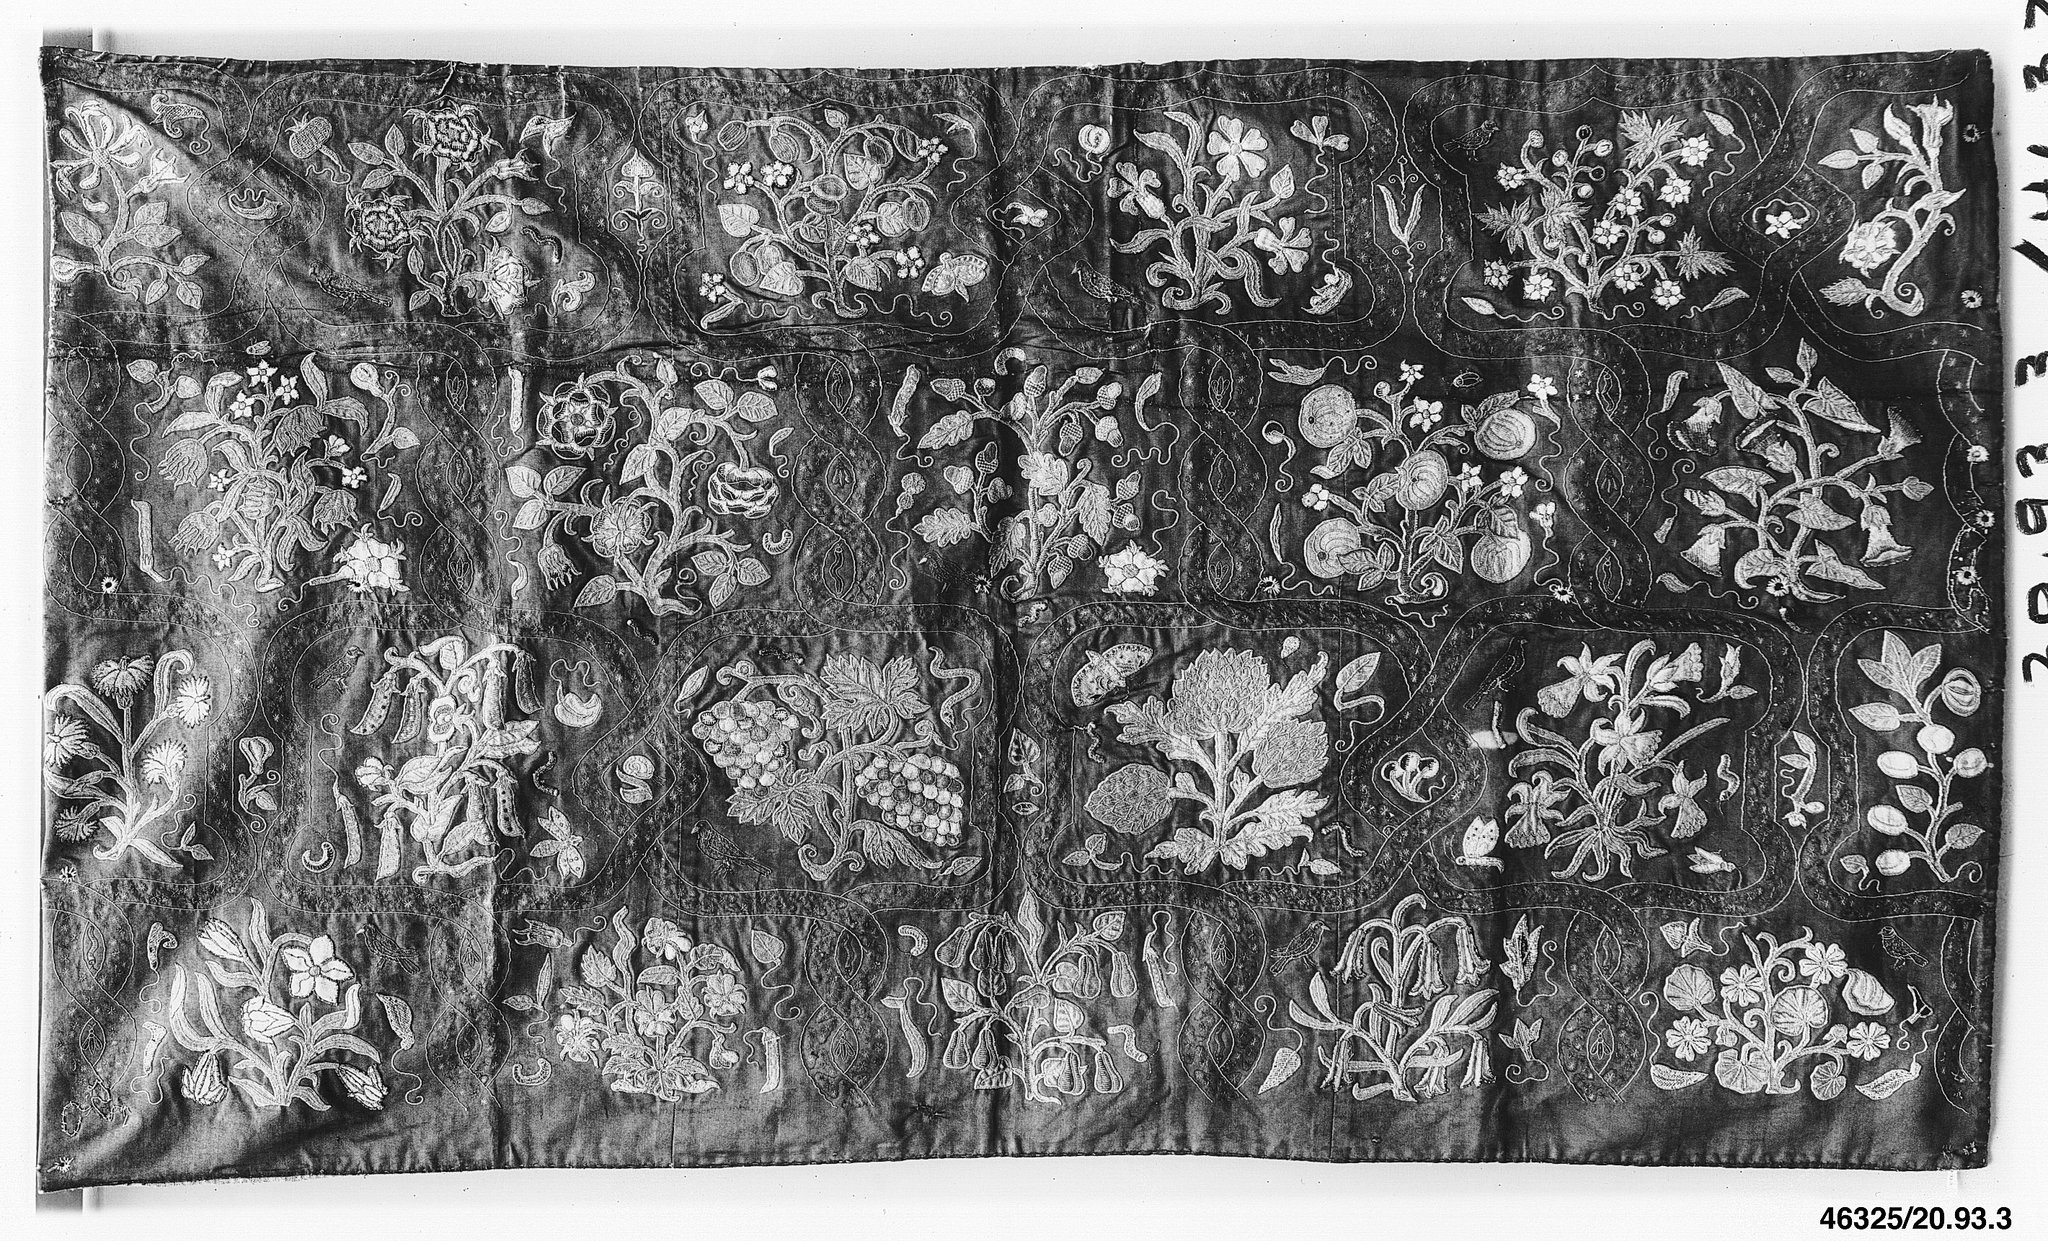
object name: piece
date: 1567-1600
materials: metal thread, silk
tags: flowers